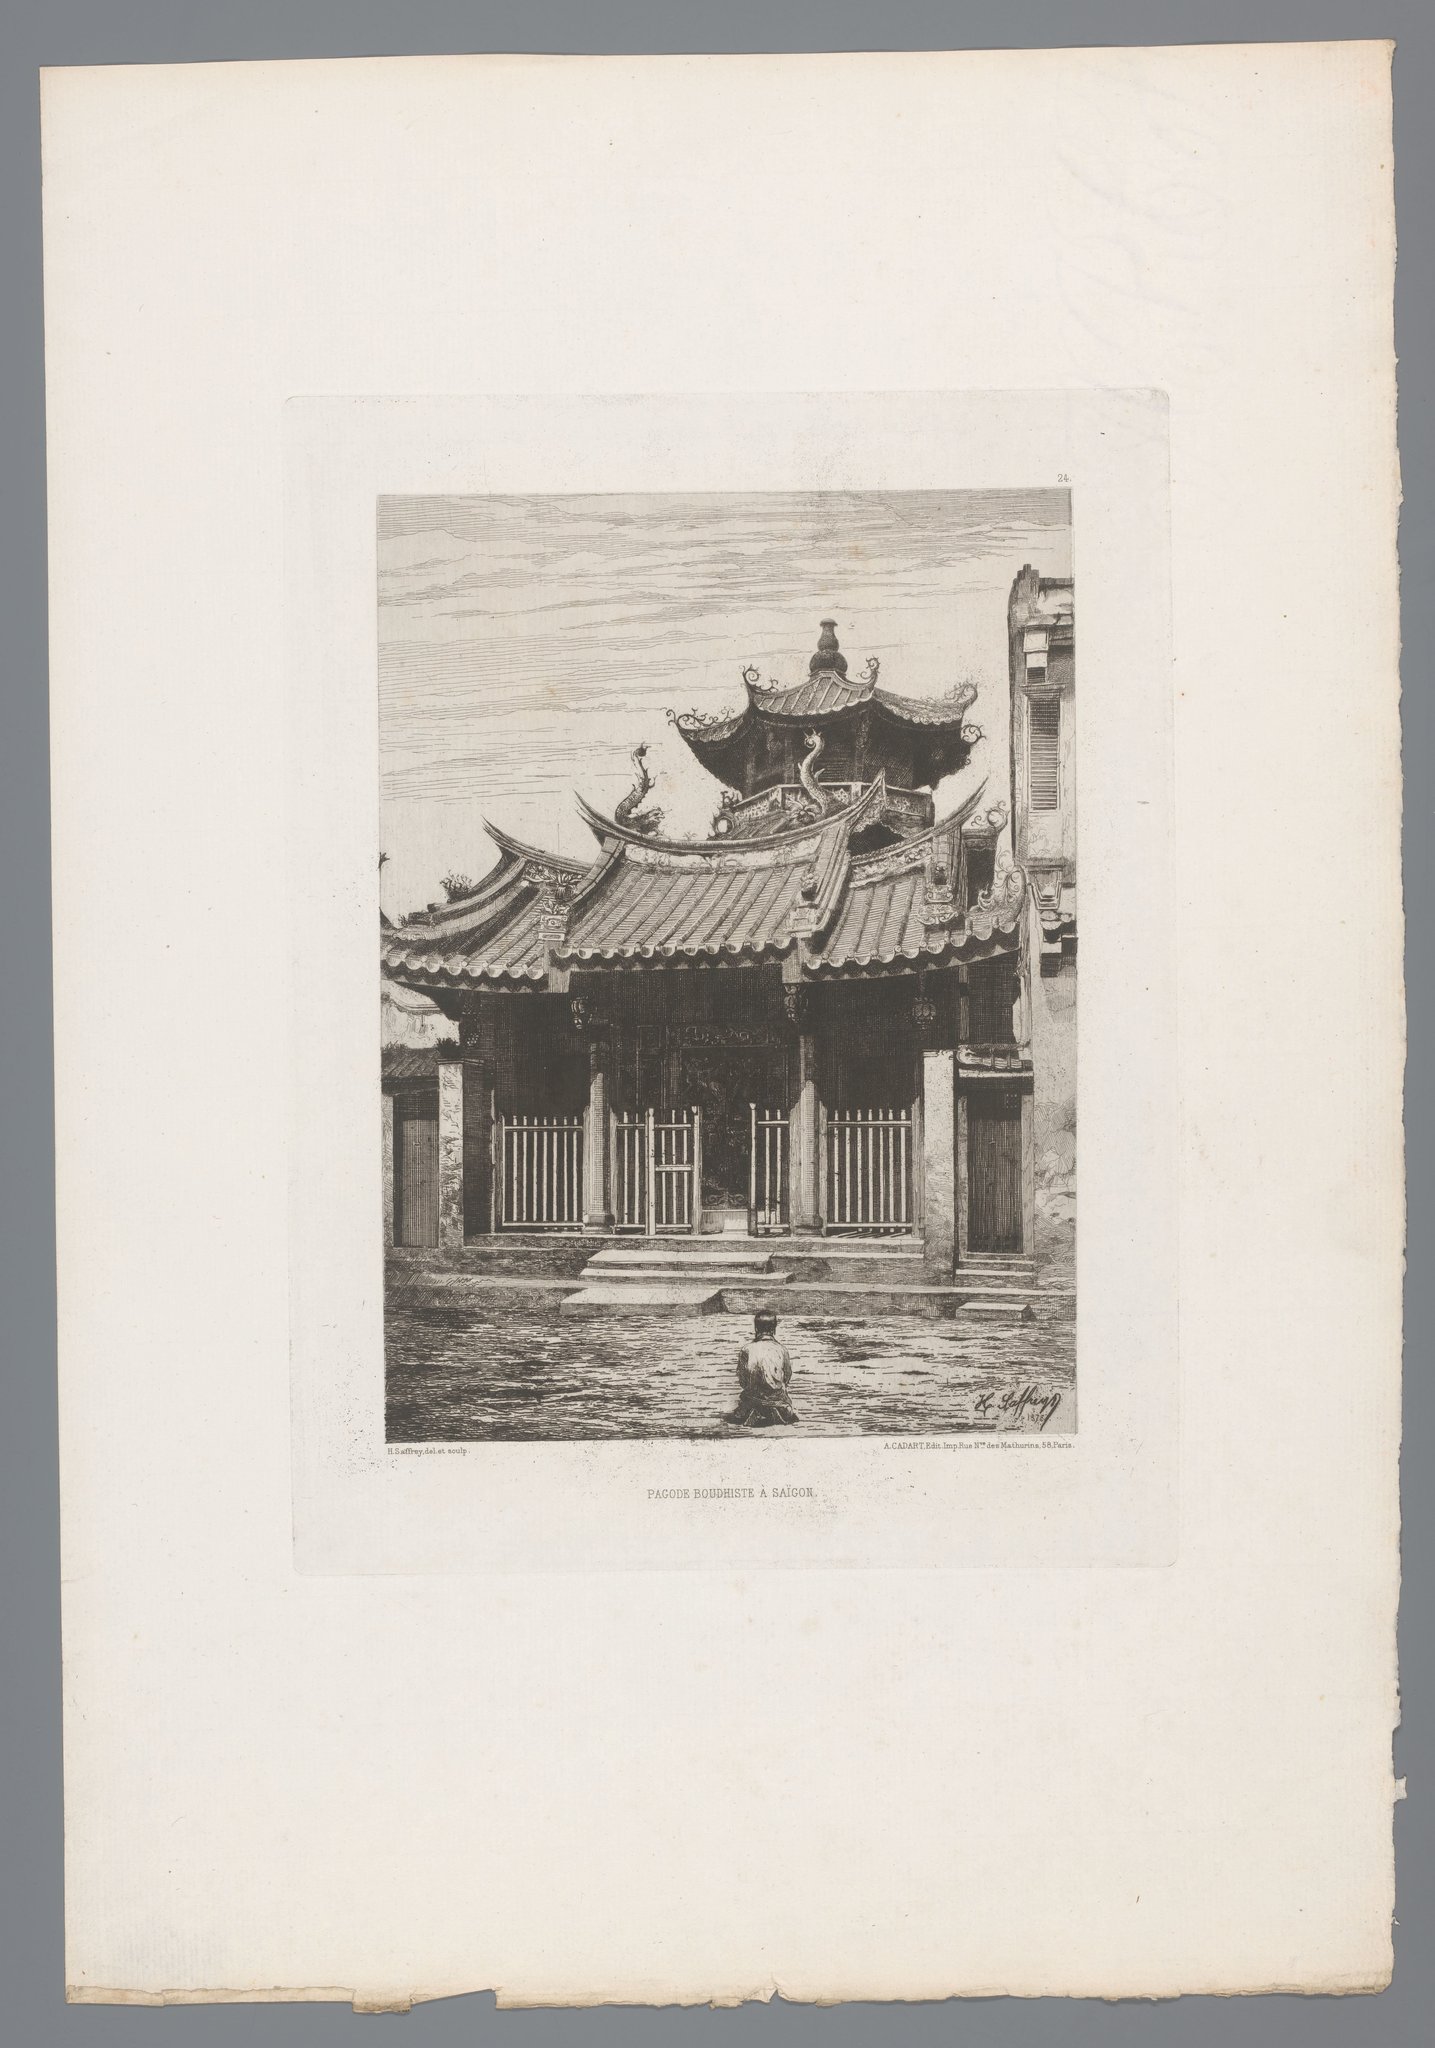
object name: print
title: Franse etsen uit 1874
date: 1874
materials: paper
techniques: drypoint, etching, intaglio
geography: paris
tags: temple, shrine ~ hinduism, buddhism, jainism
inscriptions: collector's mark: Lugt 2760, collector's mark: ‘AFE v S’, collector's mark: Lugt 2228